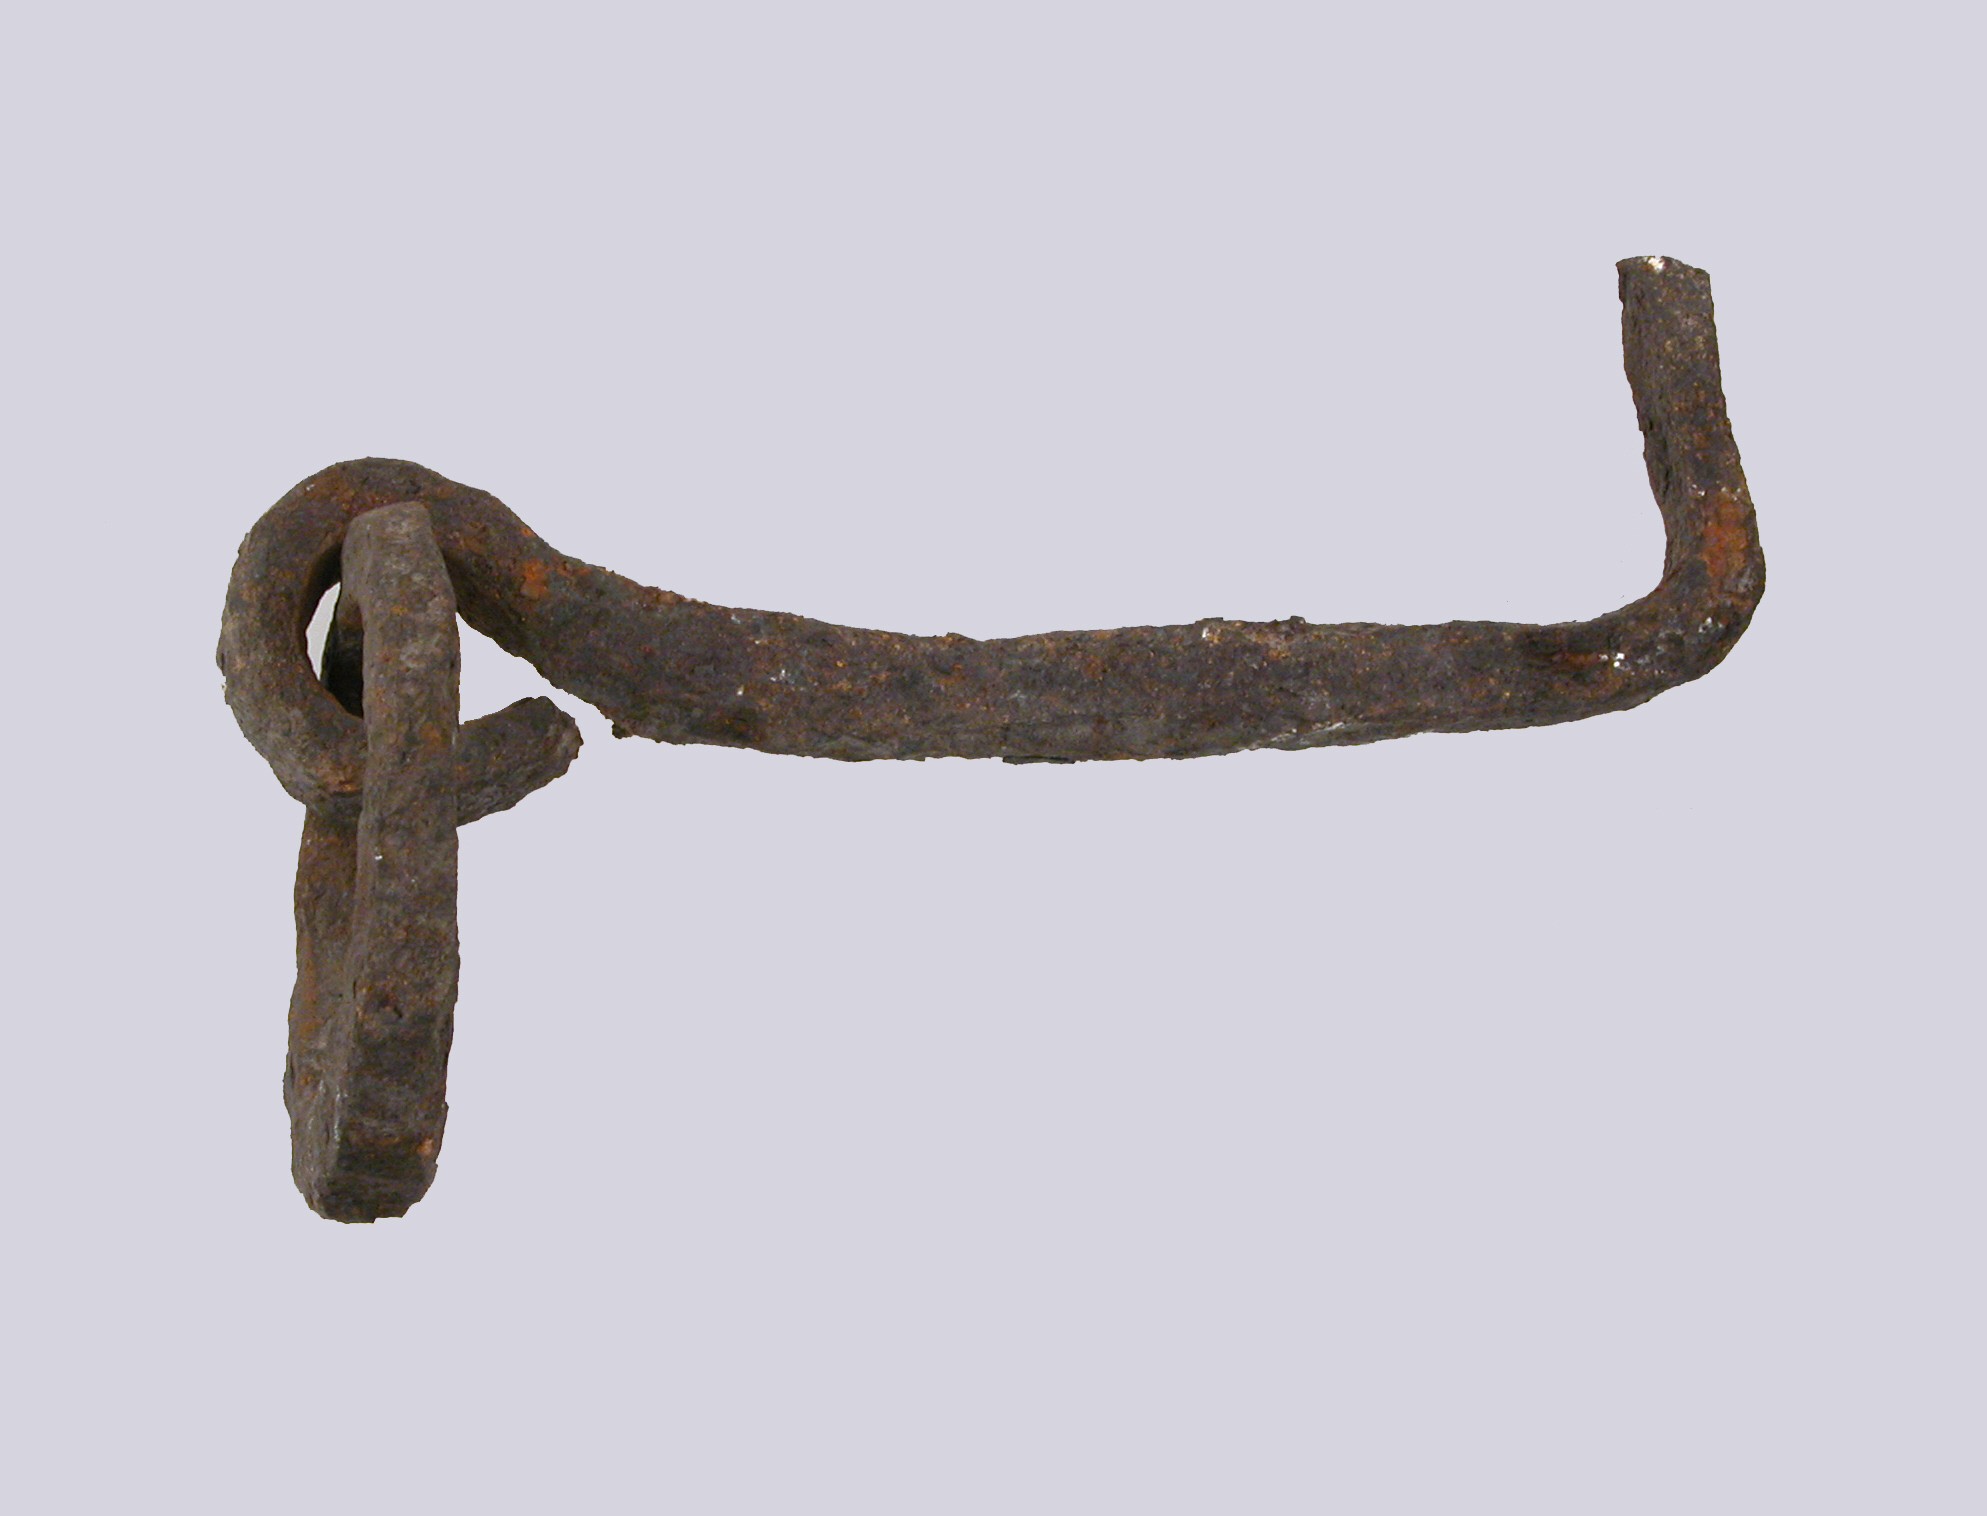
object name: ring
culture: french or german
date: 1201-1300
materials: iron